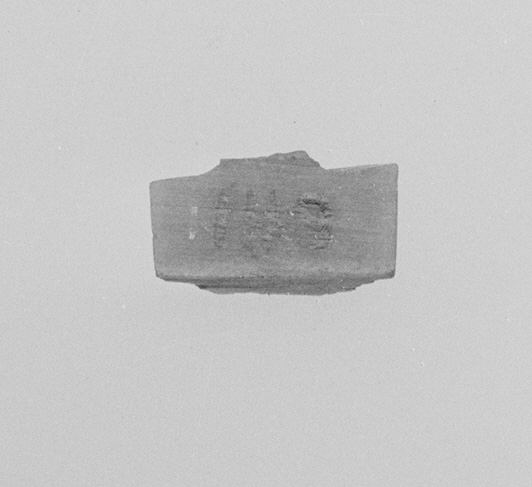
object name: fragment of ax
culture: hungary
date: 1902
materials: jade